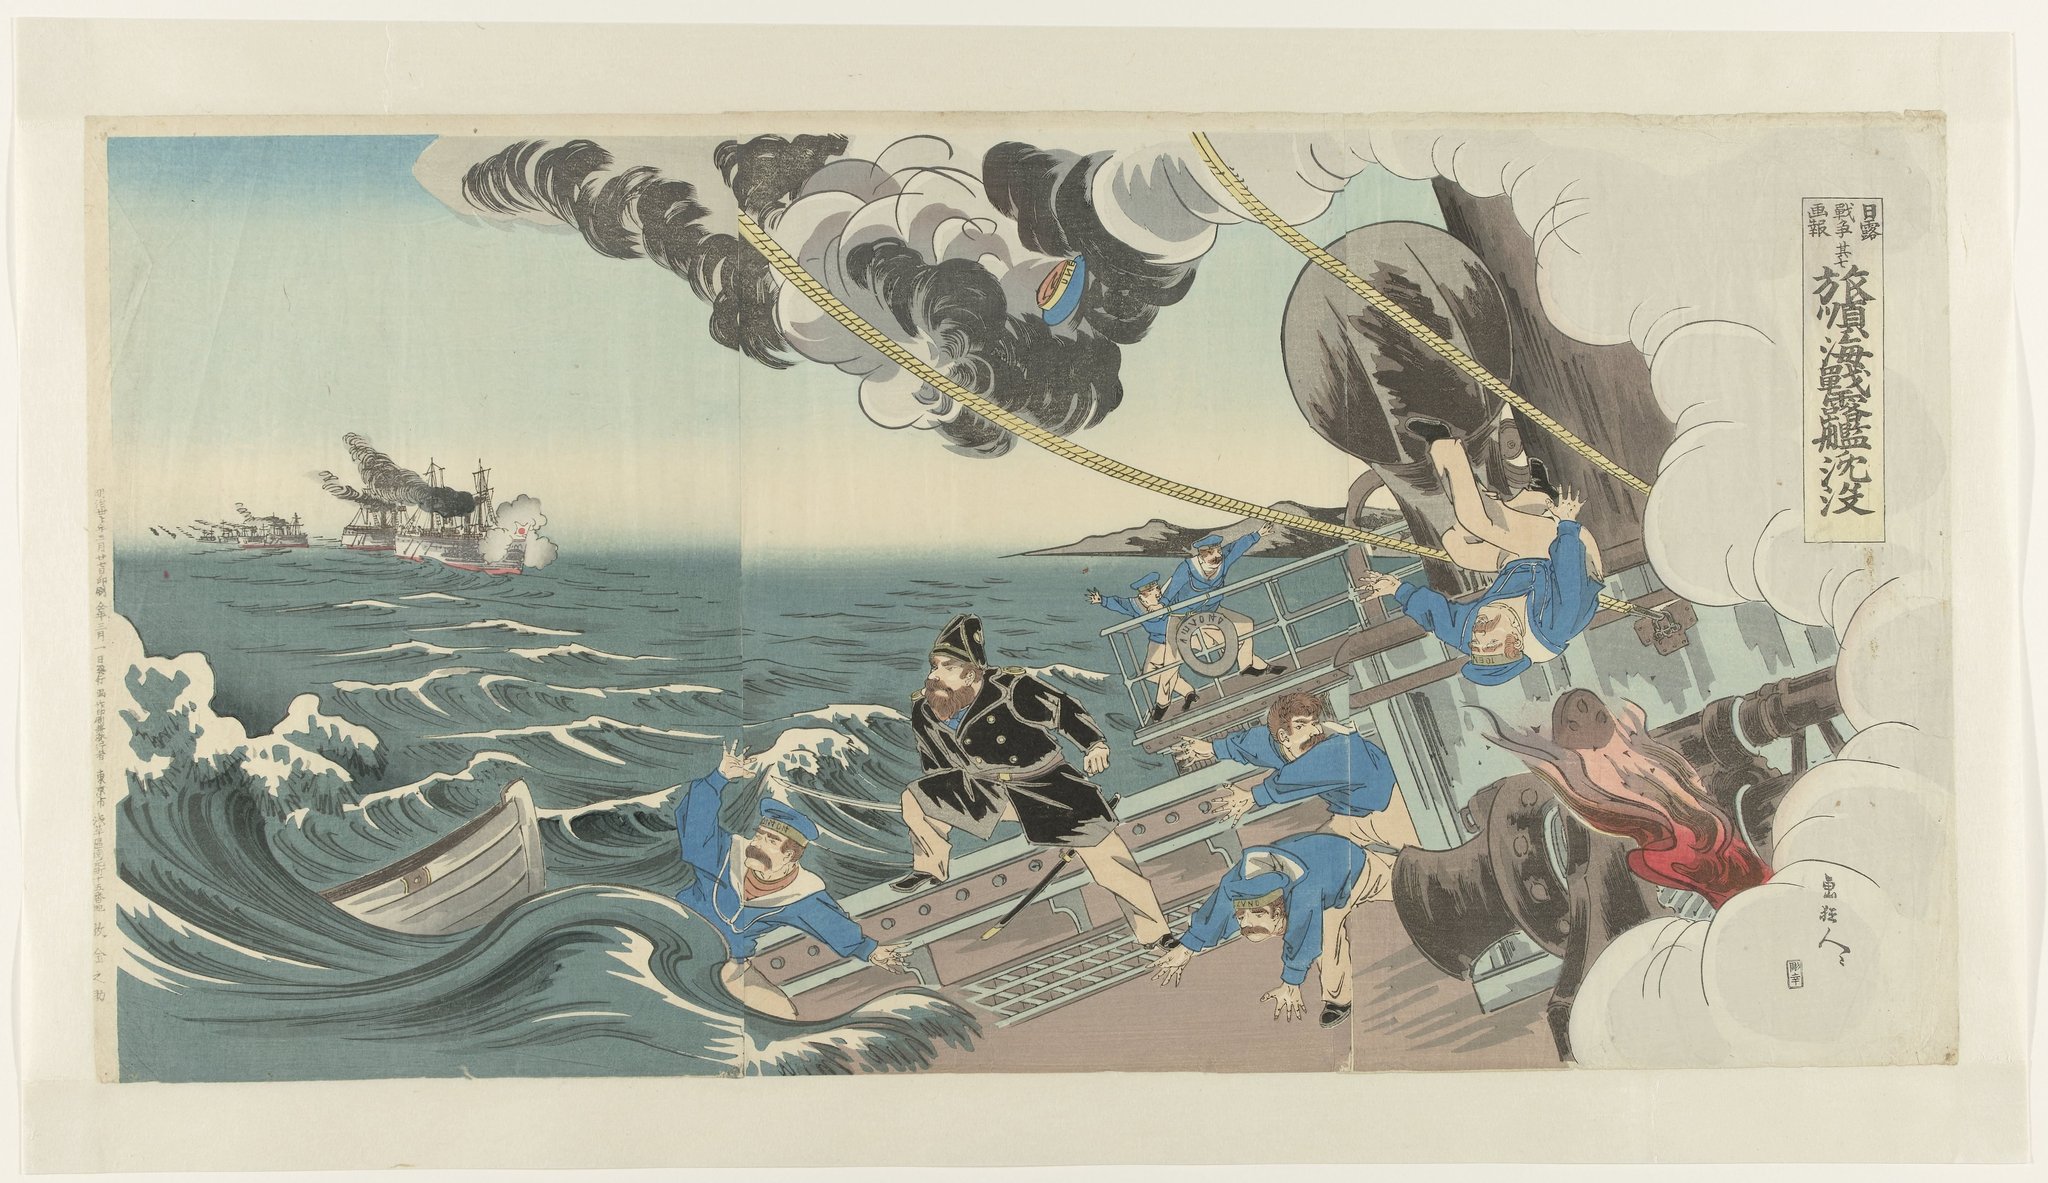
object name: triptych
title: Het zinken van een Russisch slagschip tijdens de zeeslag bij Port Arthur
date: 1904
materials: paper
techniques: woodcut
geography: japan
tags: sinking (movement in water), battle (+ naval force), sailor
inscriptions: collector's mark: Lugt 2228, label: ‘Serie 2541 no. 5’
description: Russische mariniers gaan ten onder met hun schip in de baai van Port Arthur. De zeeslag begon met een verassingsaanval van de Japanse vloot. Zij schoot torpedo's af op nietsvermoedende Russische schepen.